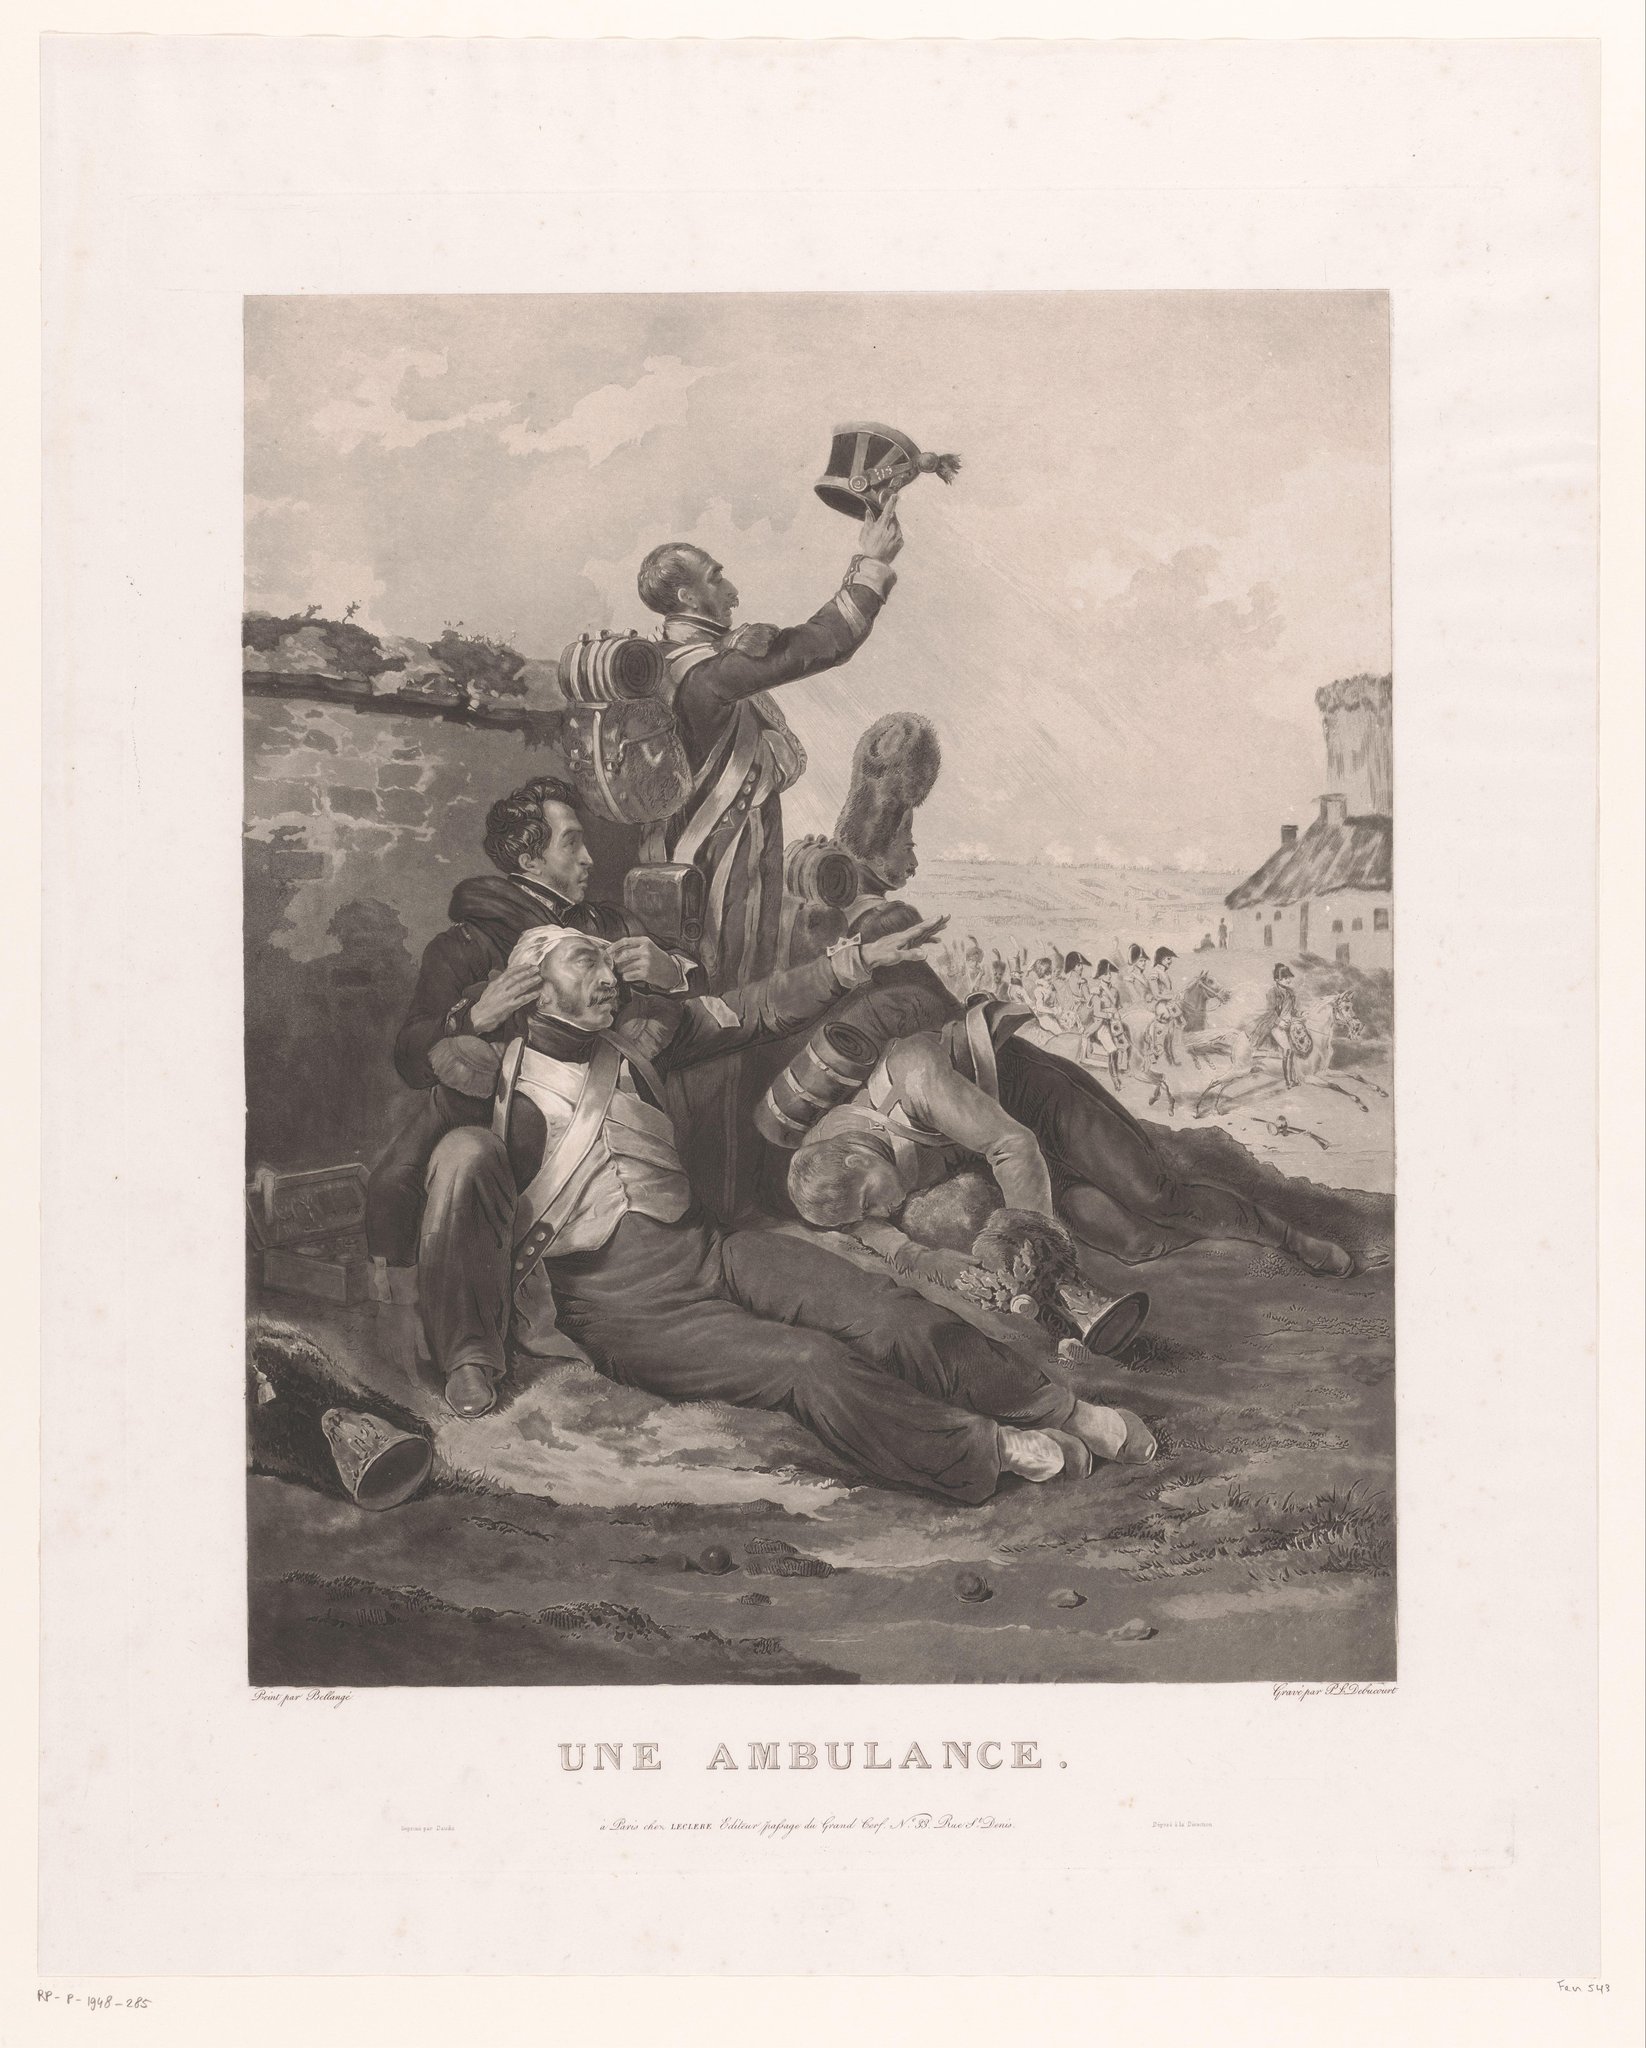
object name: print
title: Ziekenbroeder bij gewonde soldaten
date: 1827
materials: paper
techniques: aquatint, etching, roulette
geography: paris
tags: medical aid and nursing of the sick and wounded, the soldier; the soldier's life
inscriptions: : ‘Déposé à la Direction’, collector's mark: Lugt 2228